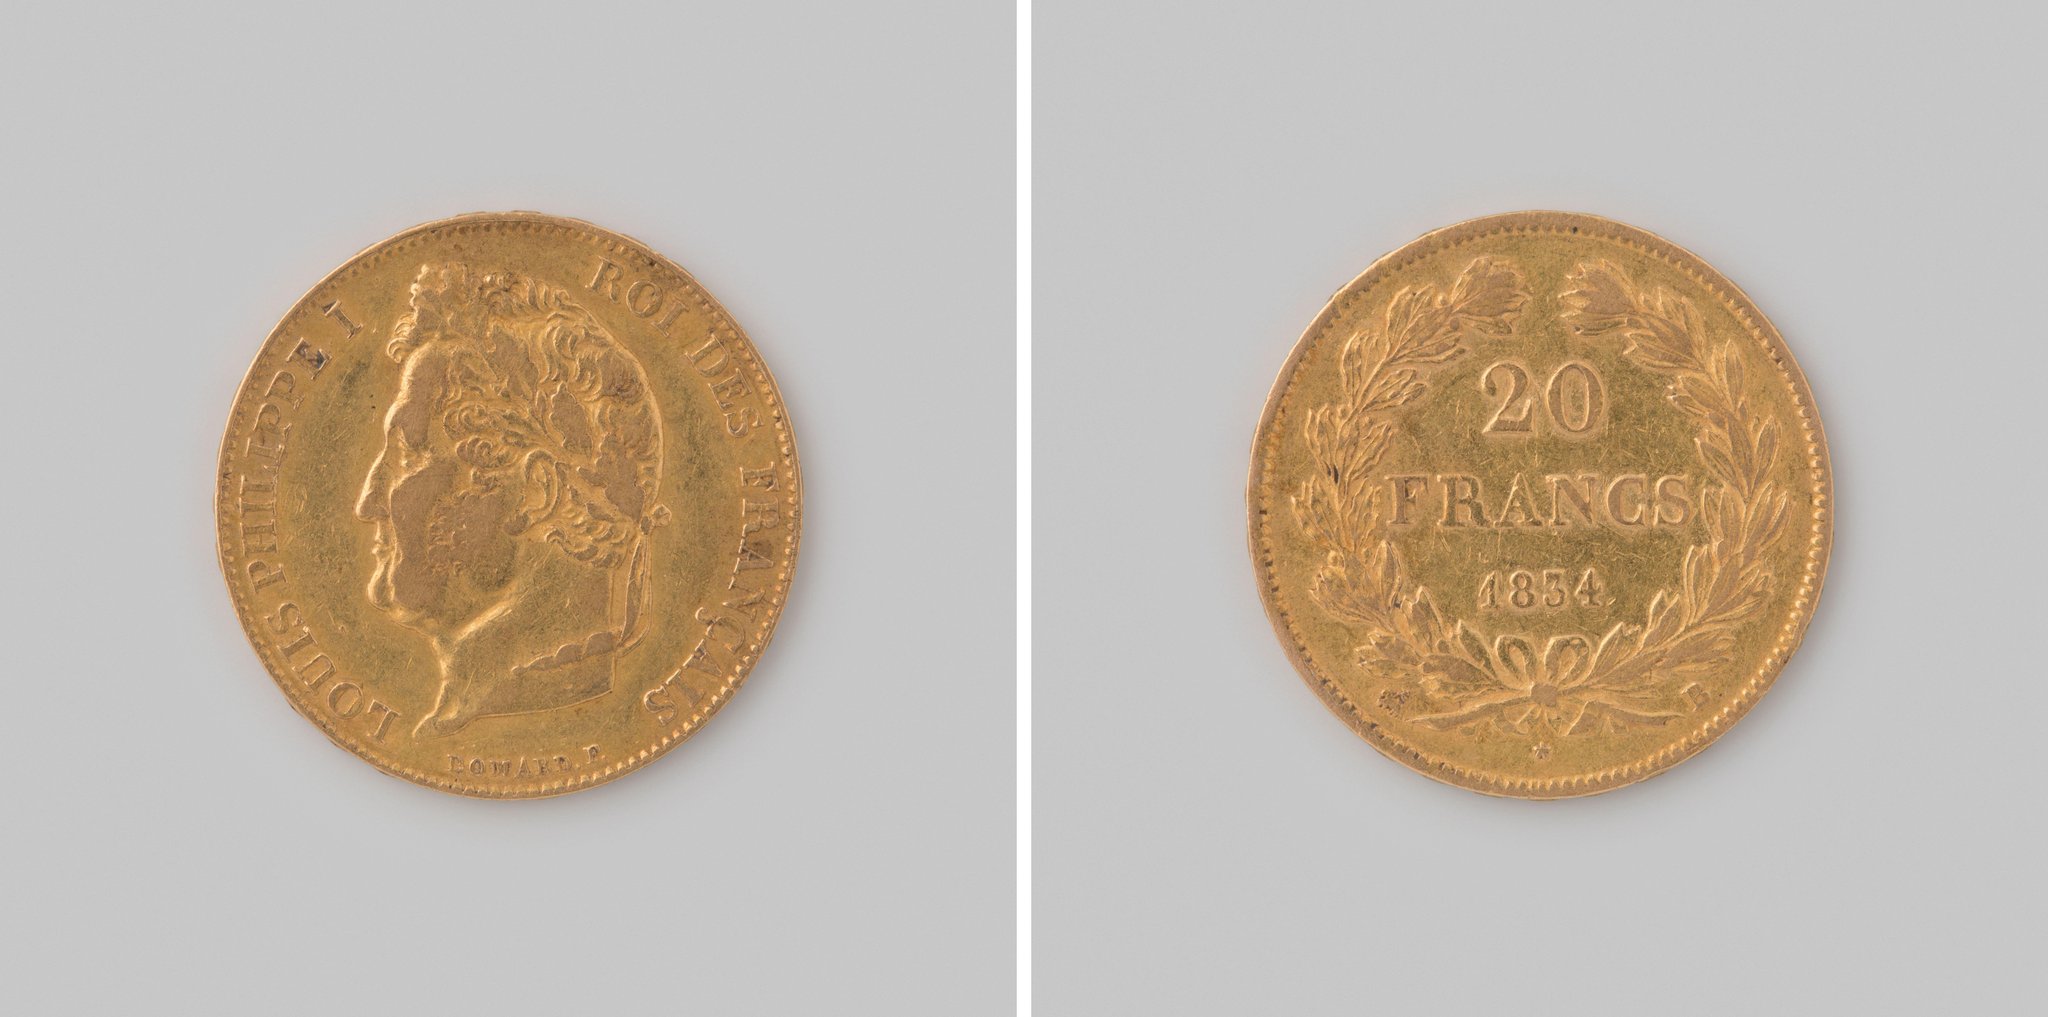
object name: twintig franc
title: Koninkrijk Frankrijk, Louis Philippe I, 20 francs, 1834 B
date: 1834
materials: gold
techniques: striking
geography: rouen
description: Gouden munt. Voorzijde: hoofd van de koning met krans van eikenbladeren naar links. Keerzijde: binnen twee samengebonden lauriertakken waarde-aanduiding in twee regls, waaronder jaartal. Rechts onderaan letter B [=Rouen]. Randschrift.